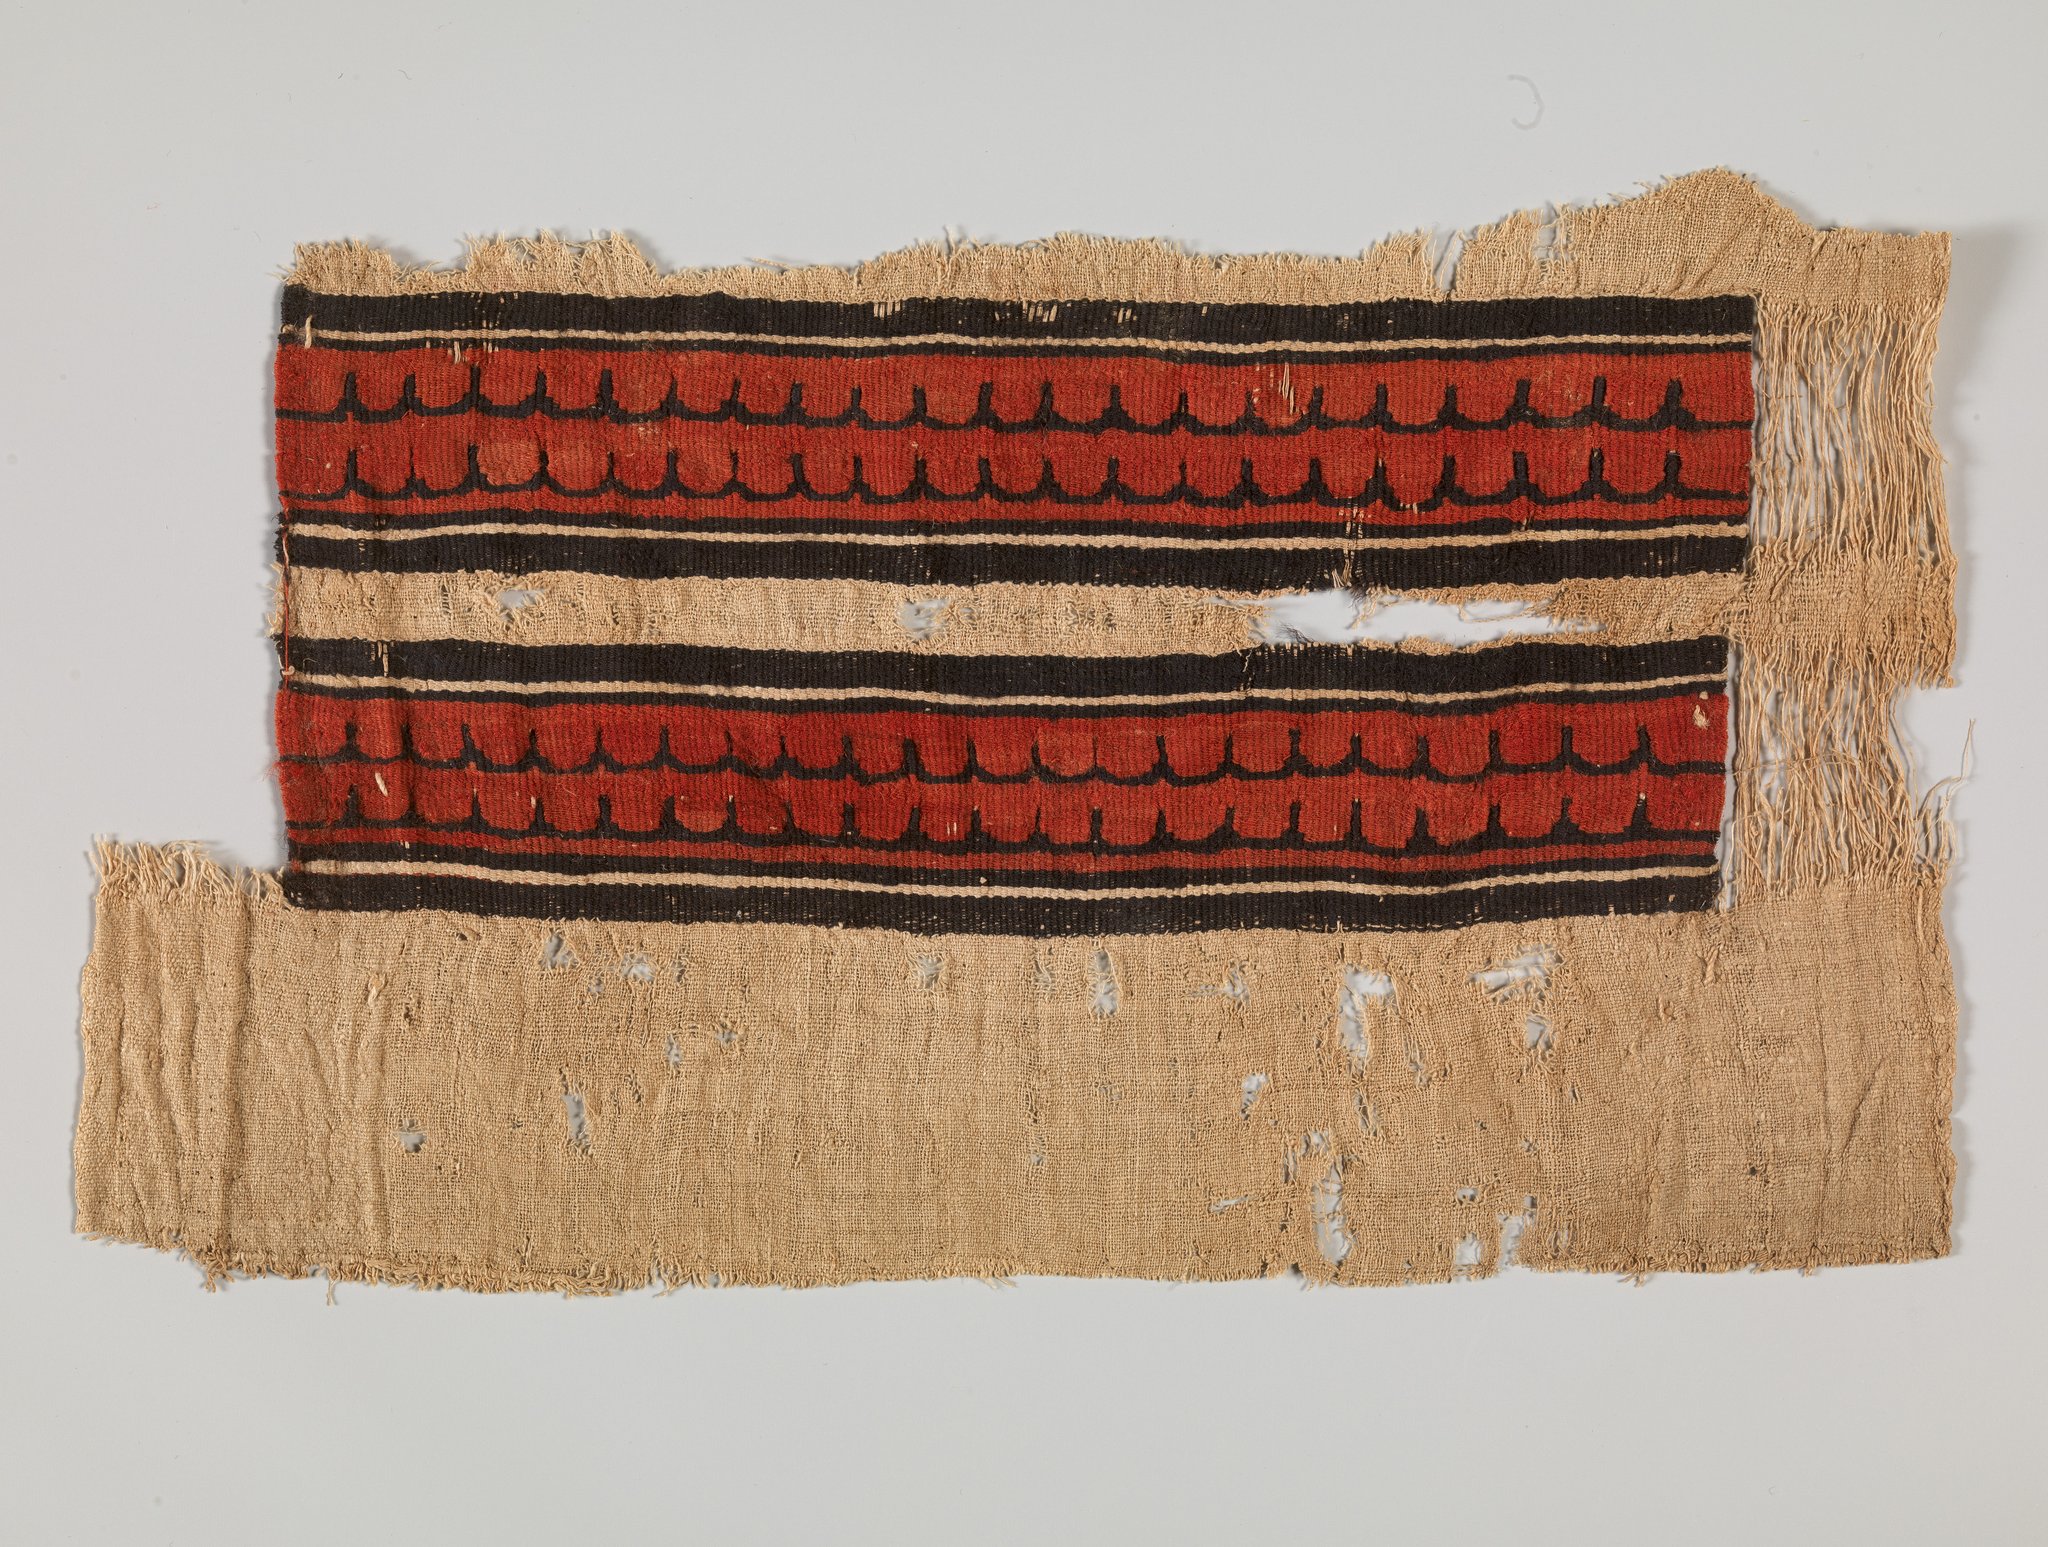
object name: textile fragment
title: Fragment of a Sleeve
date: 301-500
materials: linen, wool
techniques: weave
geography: egypt